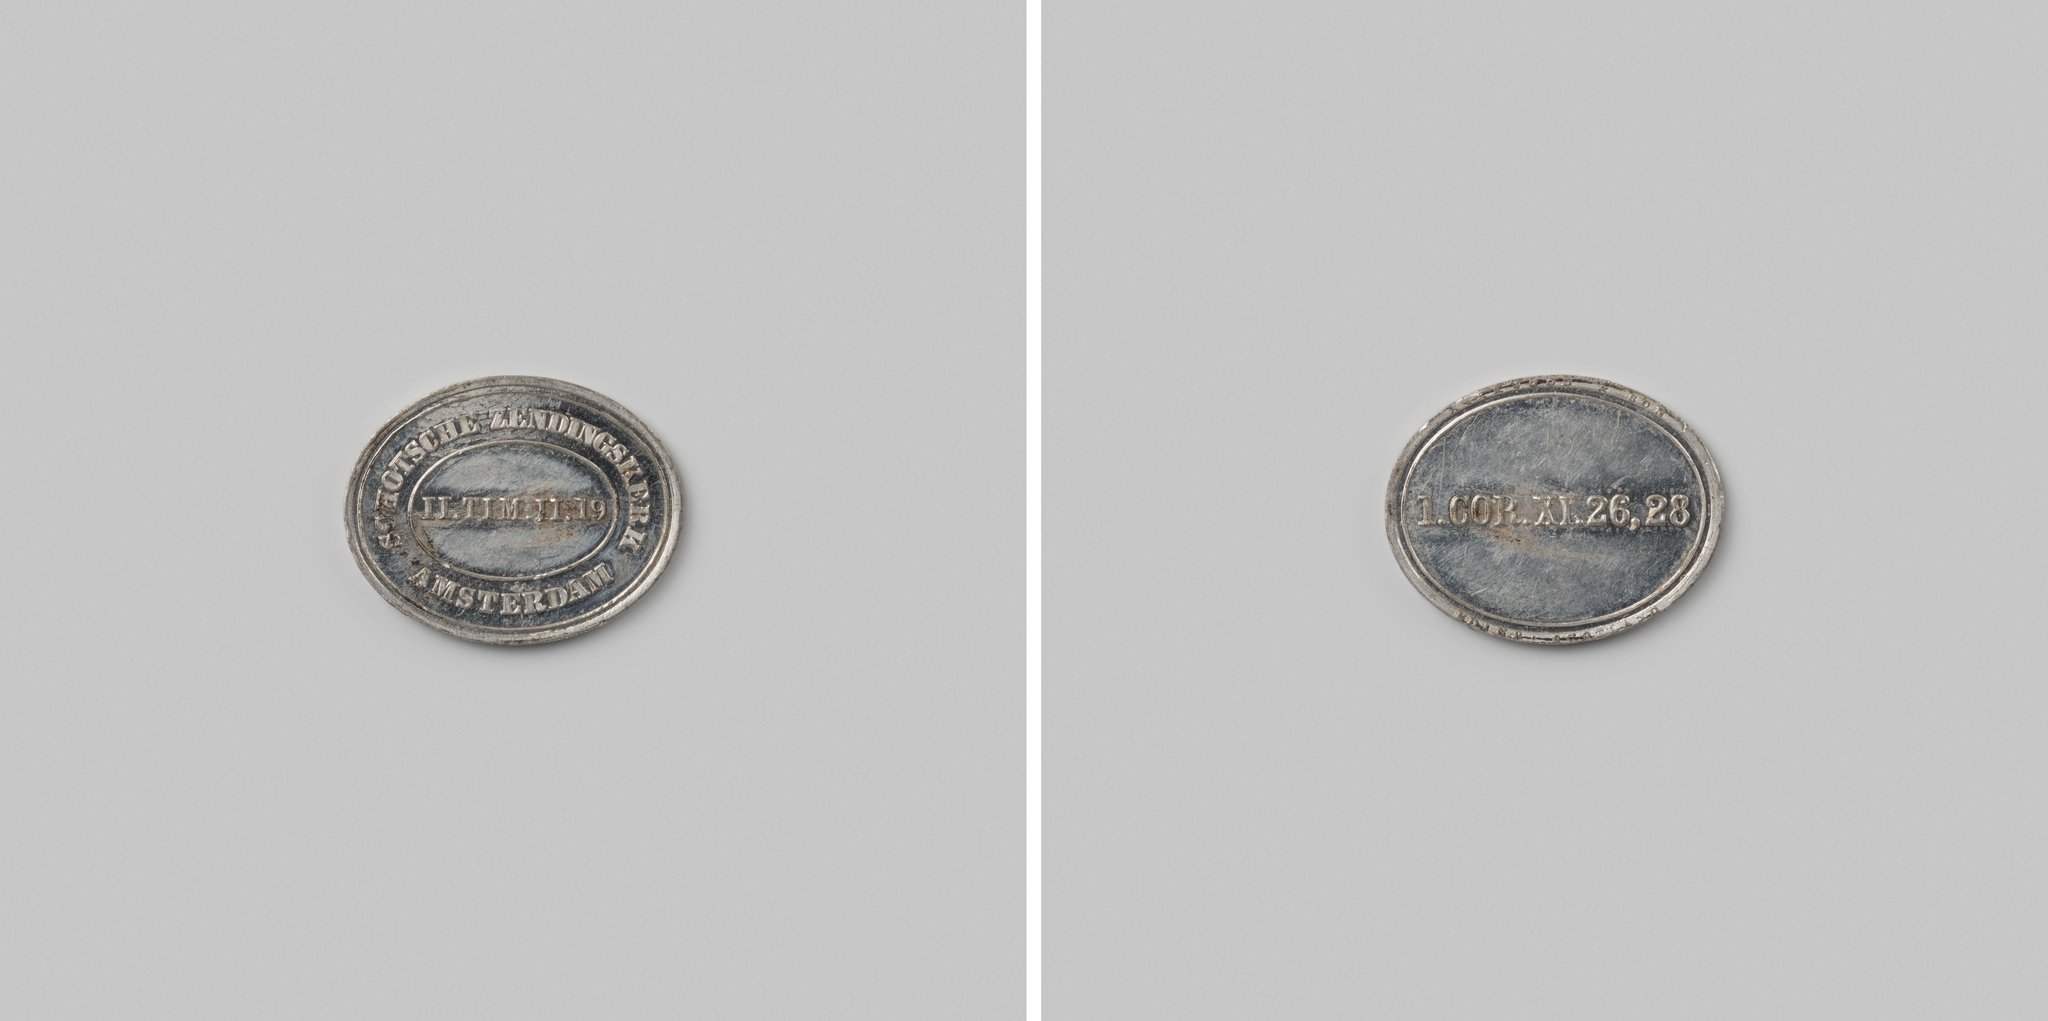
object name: devotional medal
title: Schotsche zendingskerk te Amsterdam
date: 1800-1900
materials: metal alloy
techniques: striking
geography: edinburgh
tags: amsterdam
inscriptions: inscription: ‘1 . COR . XI . 26, 28’, inscription: ‘II . TIM . II . 19’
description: Ovale penning. Voorzijde: opschrift binnen omschrift. Keerzijde: opschrift.